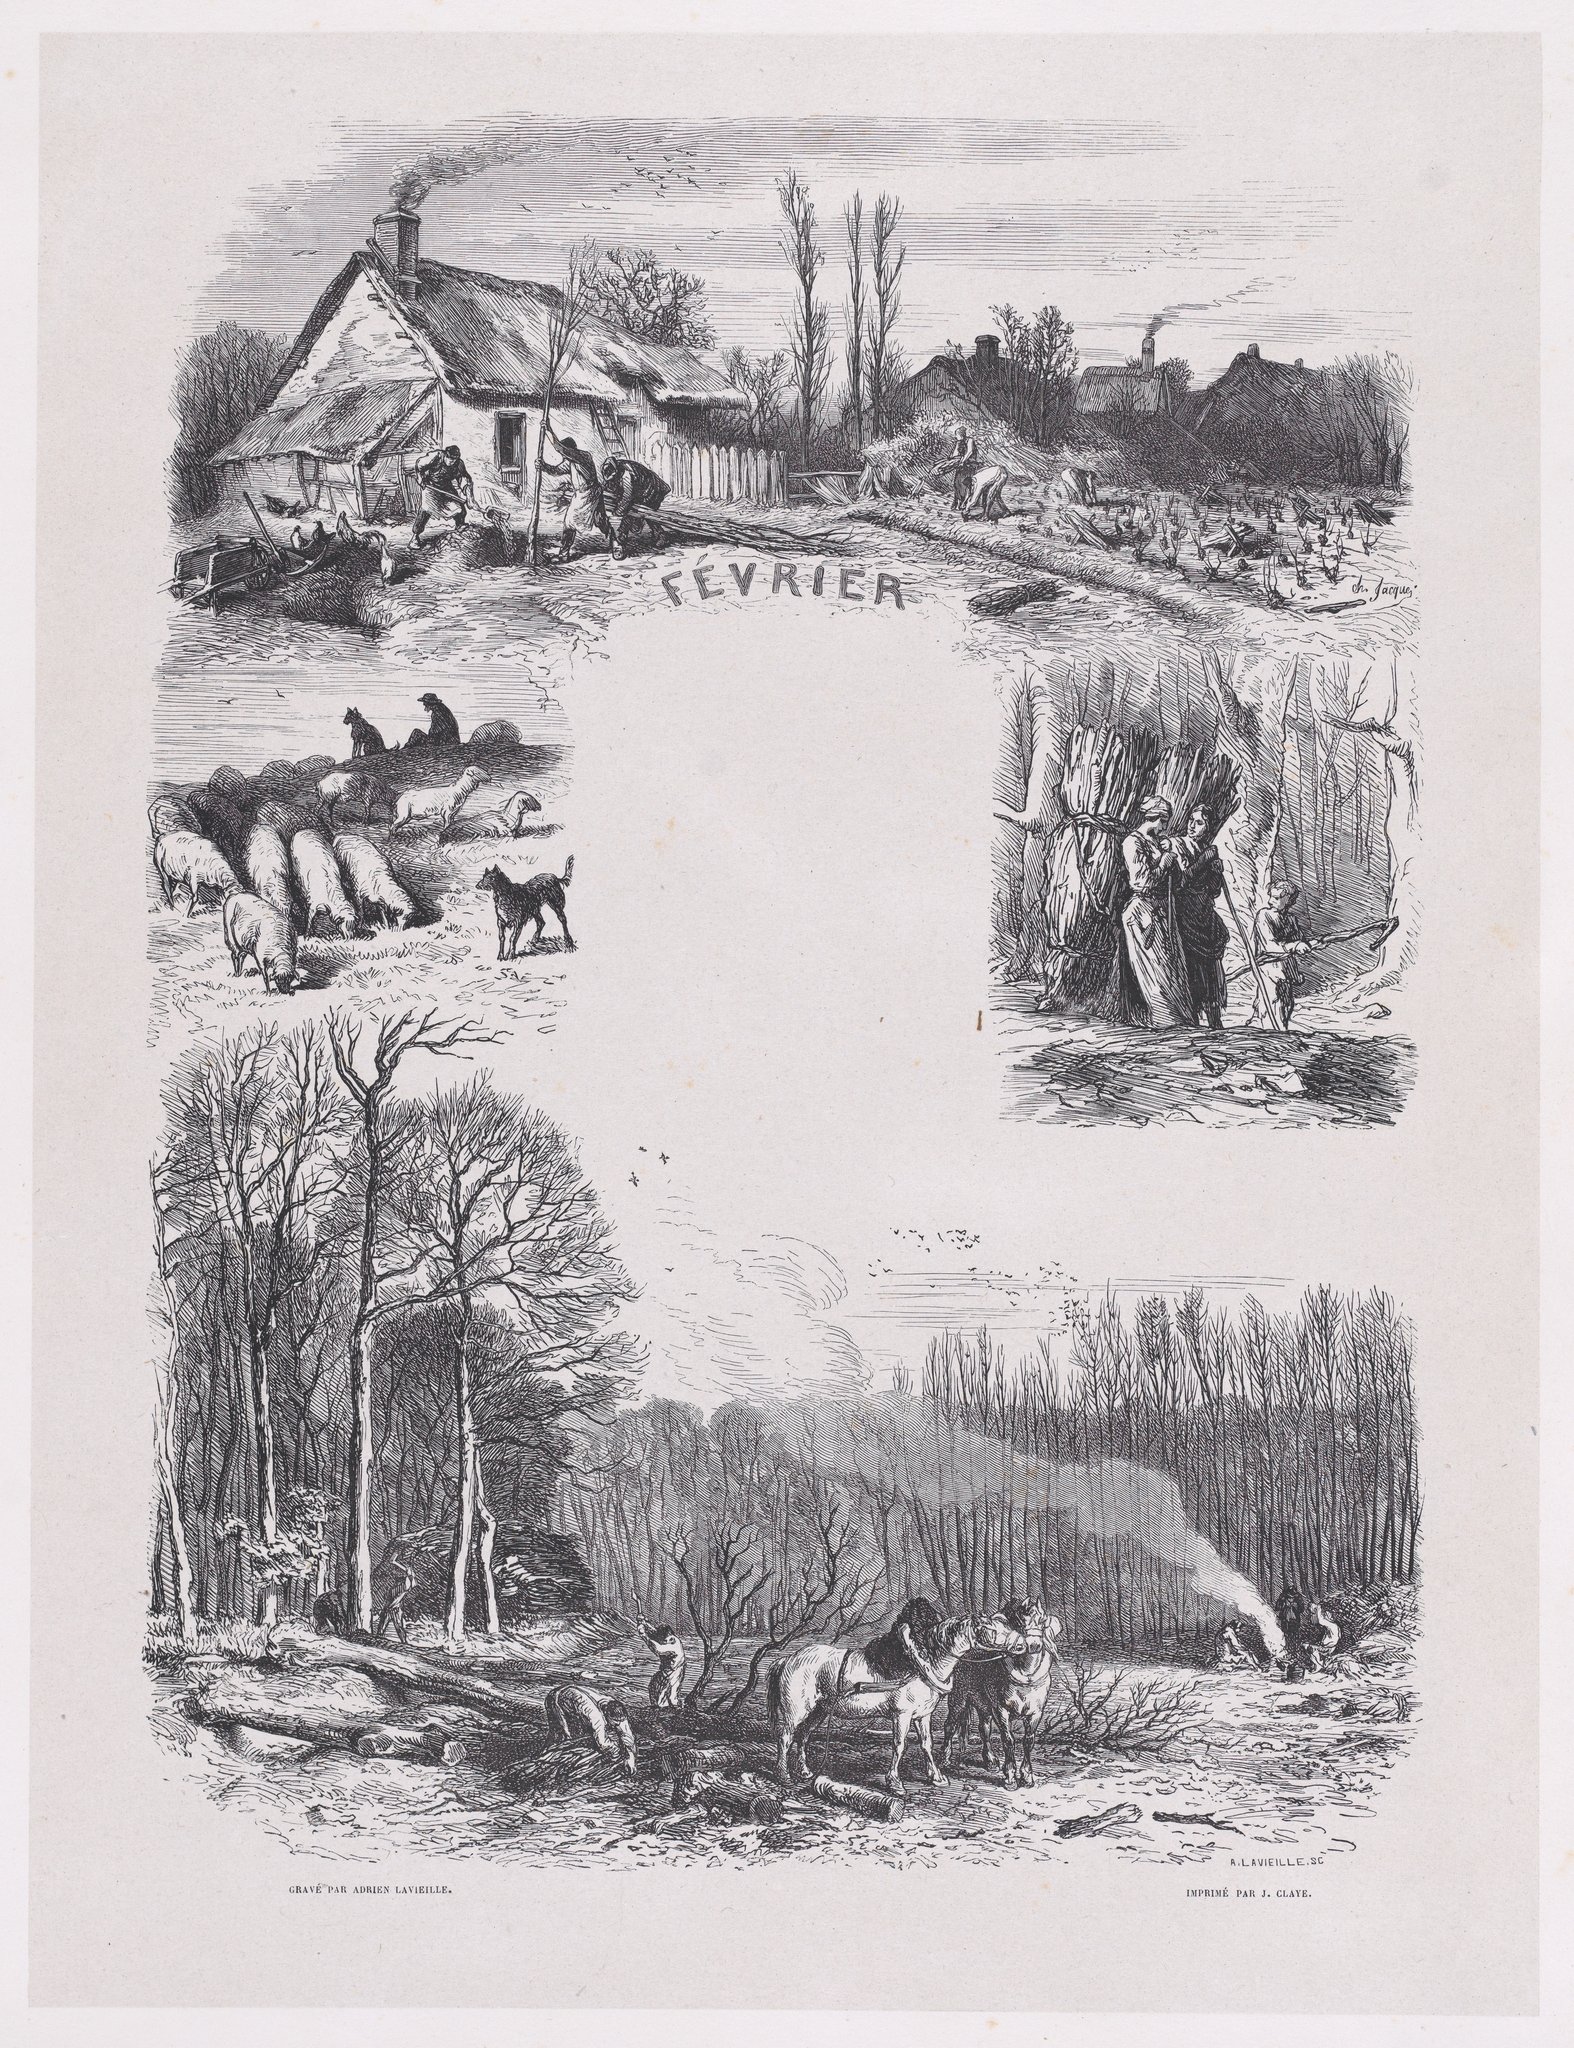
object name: print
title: February, from "Album of Rustic Subjects"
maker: charles émile jacque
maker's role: artist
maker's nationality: french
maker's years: 1813-1894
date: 1859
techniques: engraving